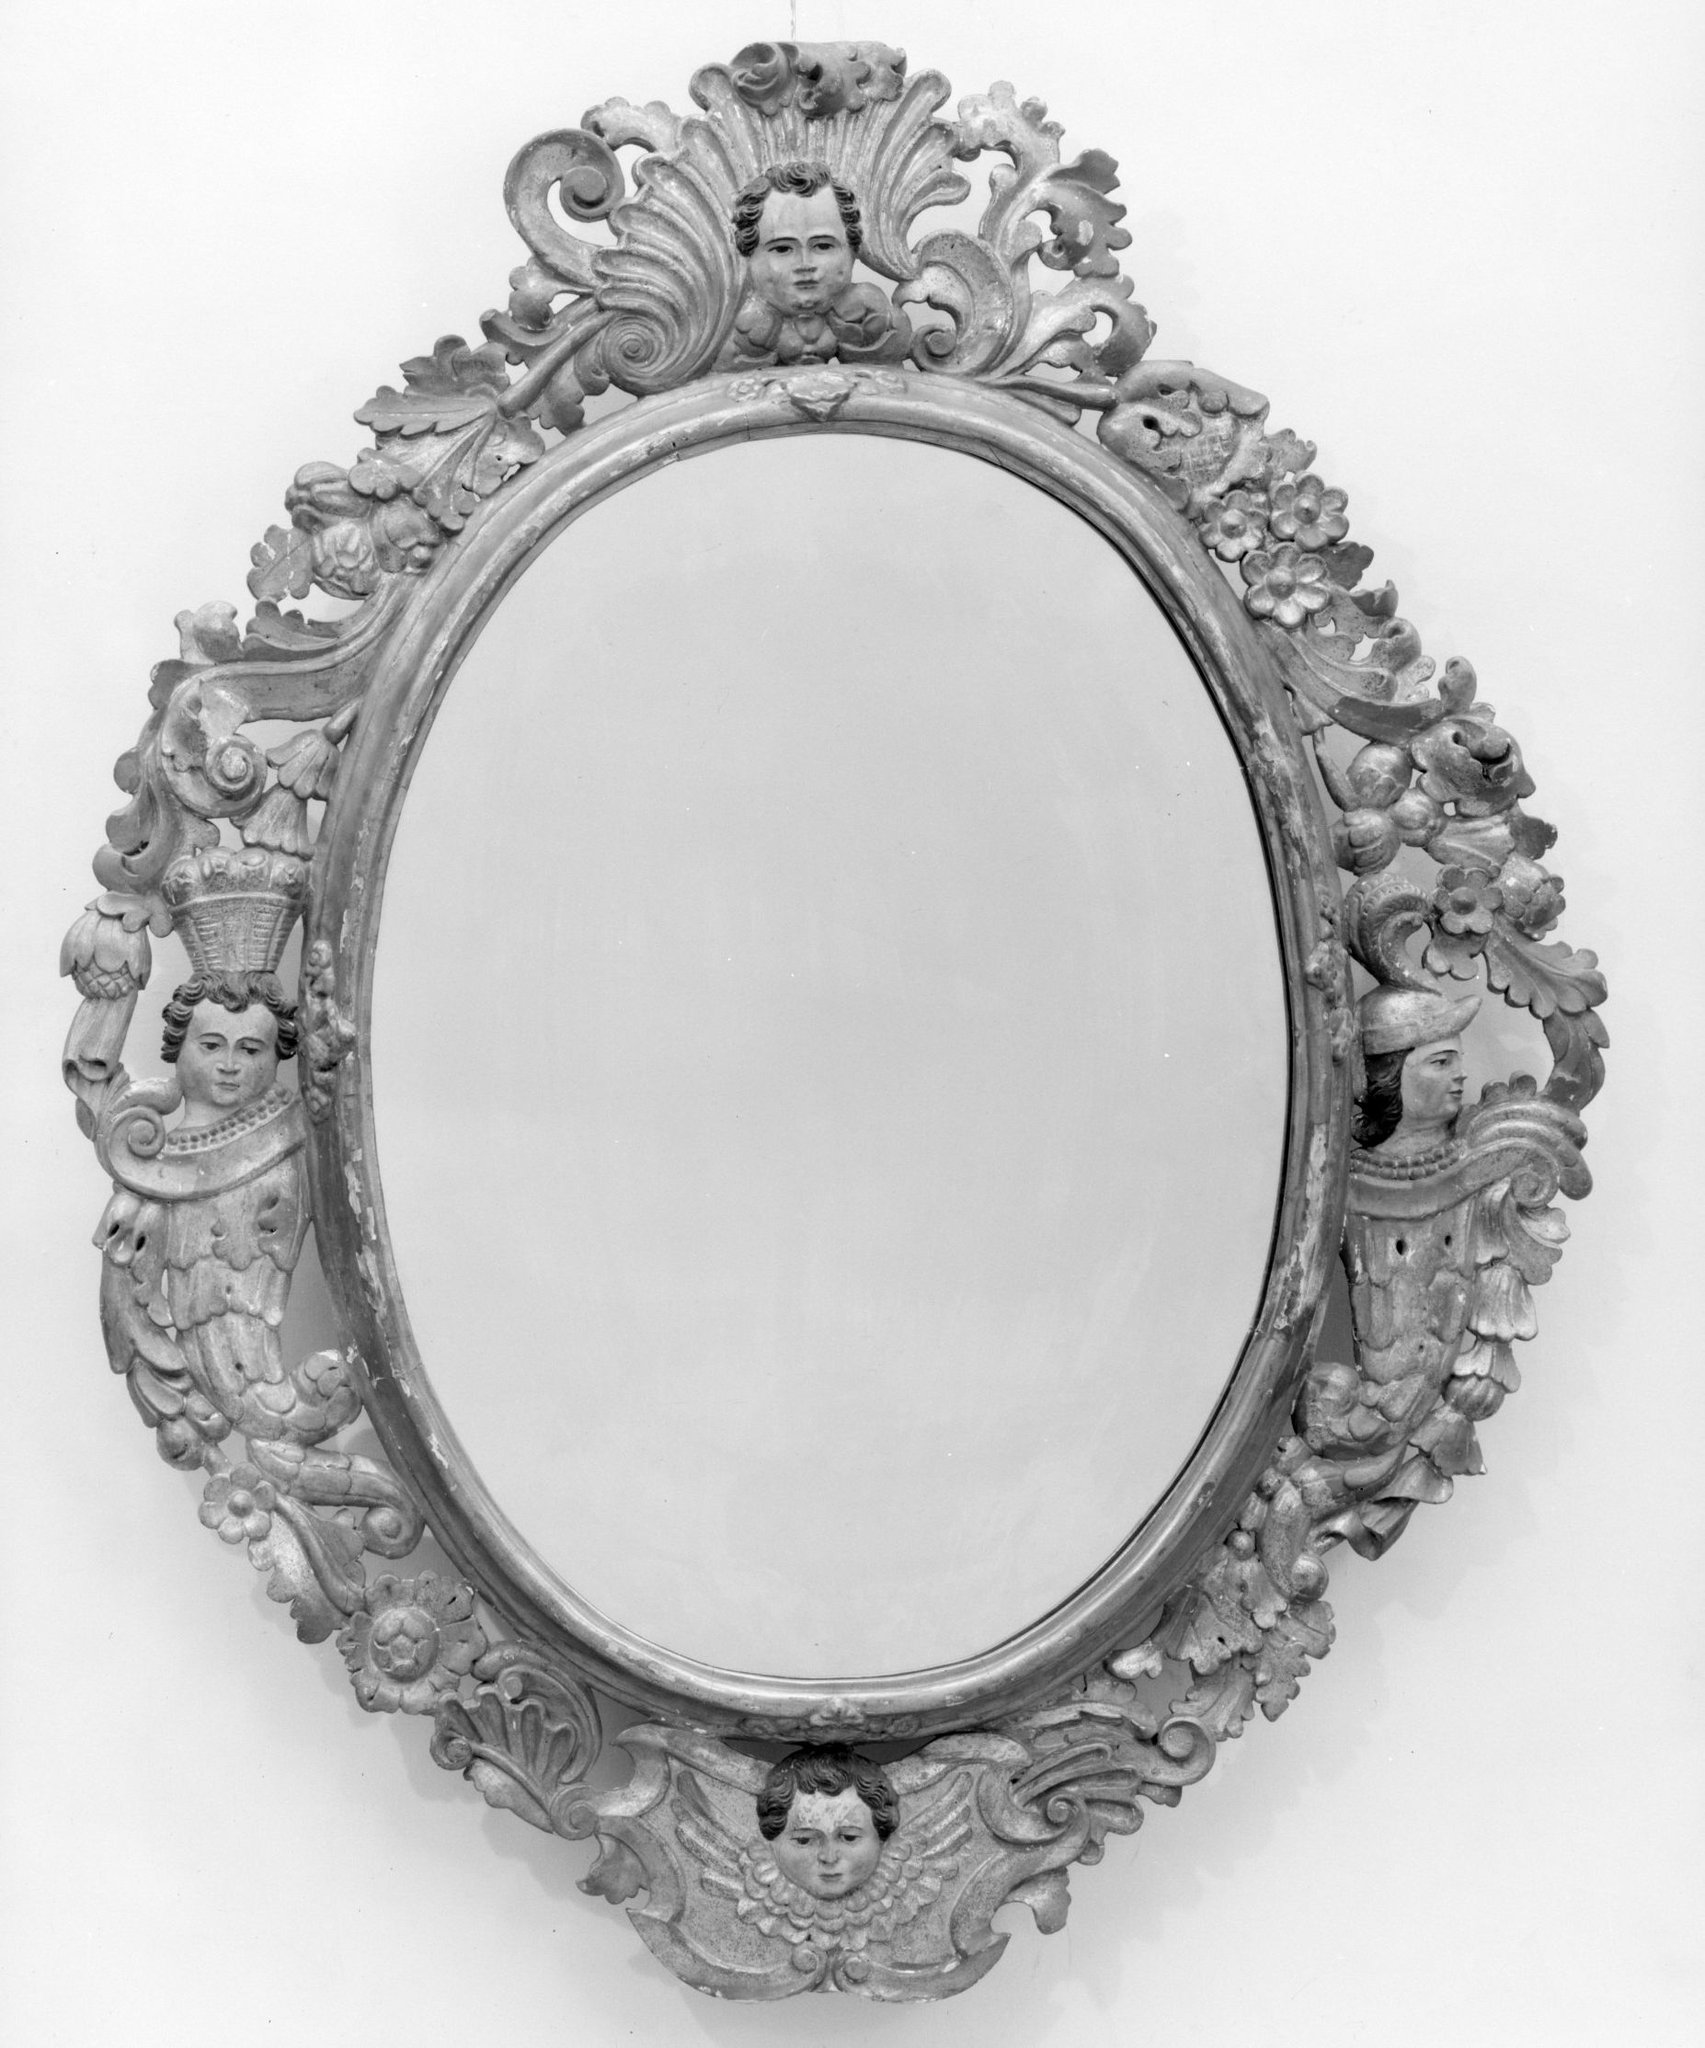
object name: looking glass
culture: mexican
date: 1700-1800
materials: glass, wood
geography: mexico